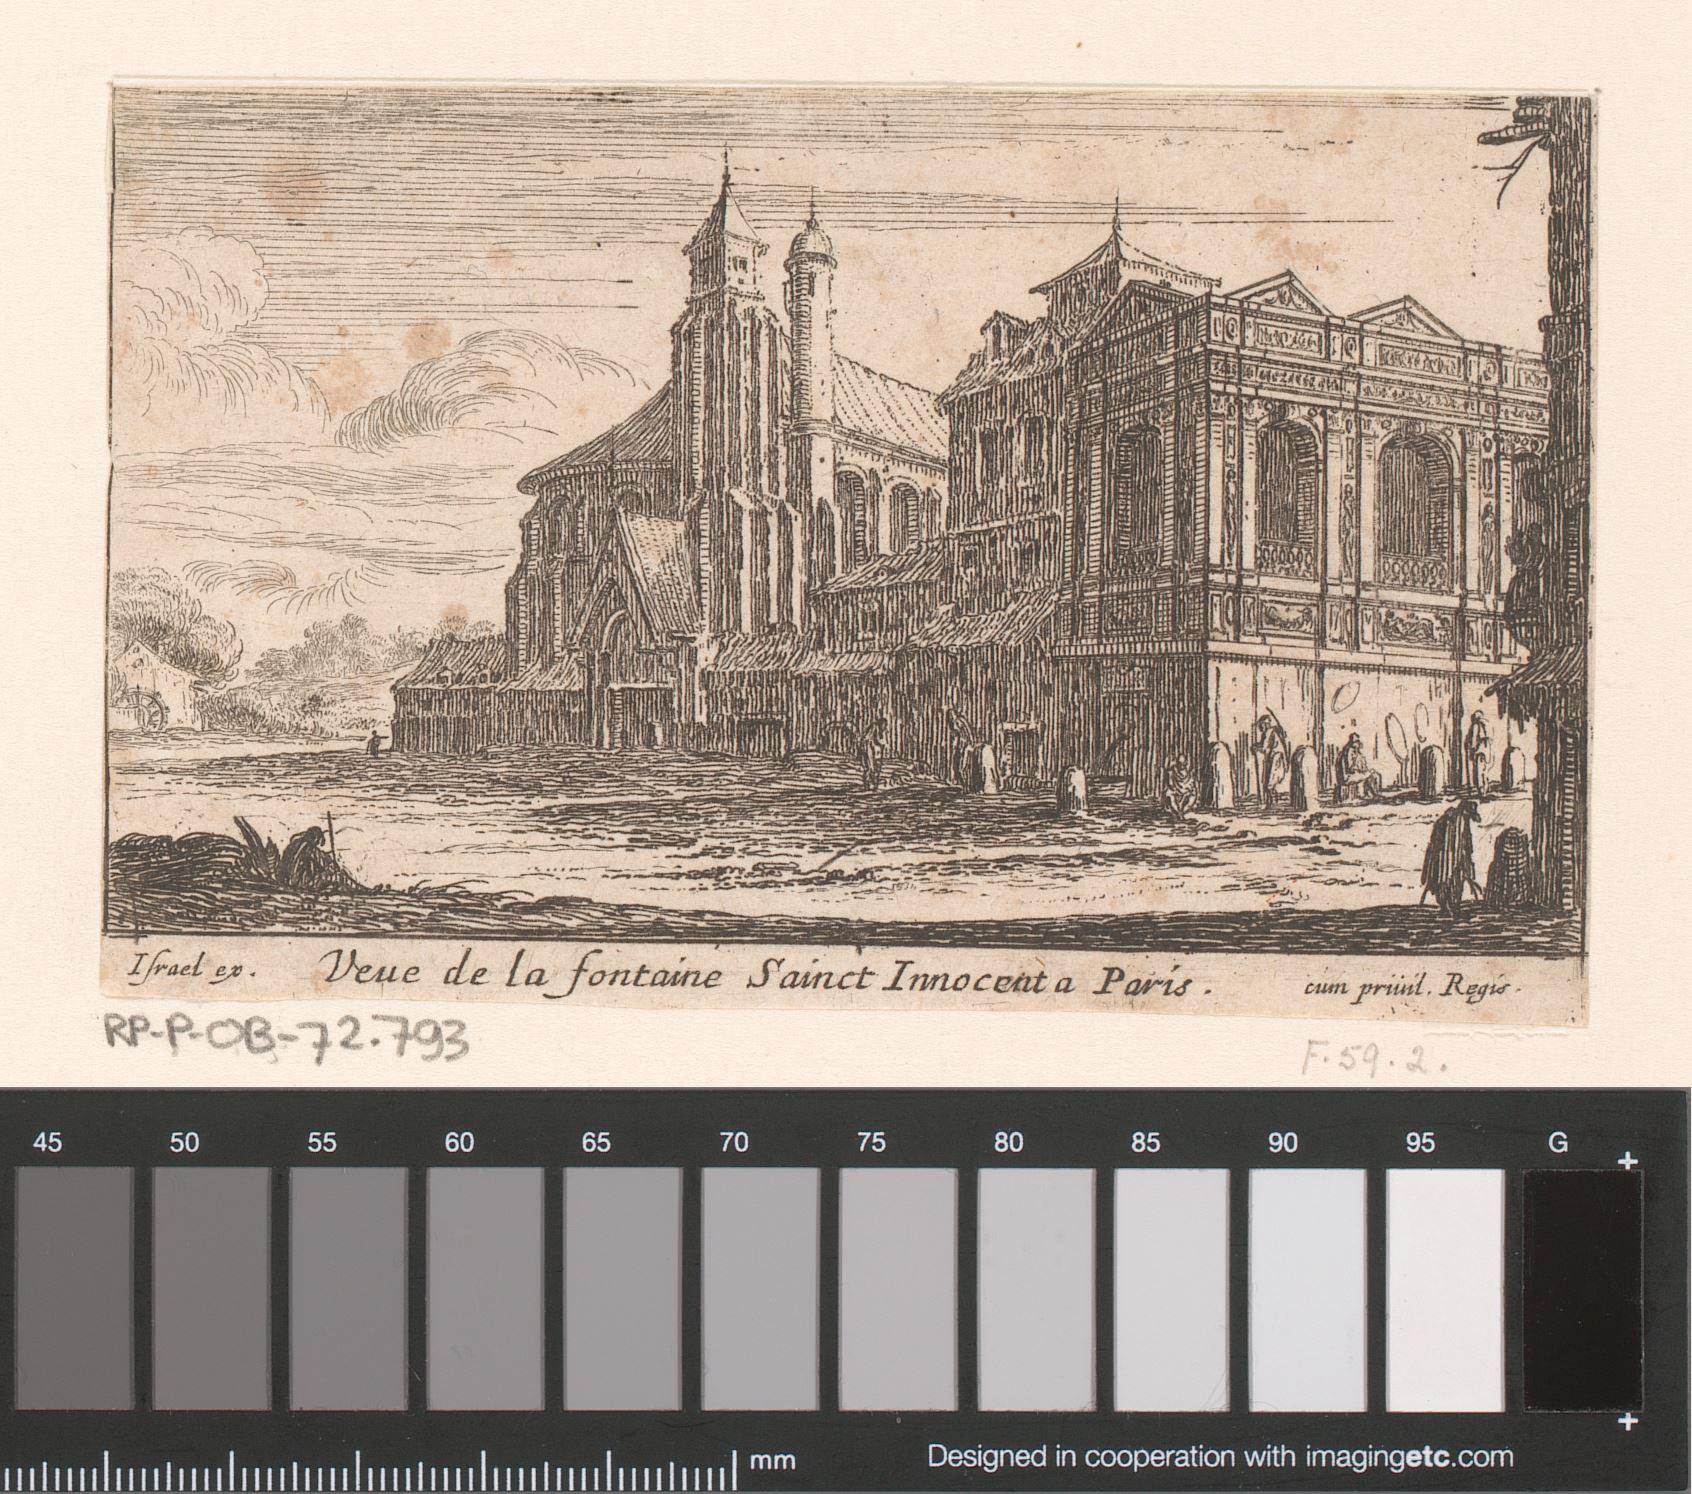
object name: print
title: Veue de la fontaine Sainct Innocent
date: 1631-1661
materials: paper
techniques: etching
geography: france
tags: city-view, and landscape with man-made constructions, ornamental fountain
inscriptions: collector's mark: Lugt 240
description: Prent maakt deel uit van een ongenummerde serie van zeven prenten.